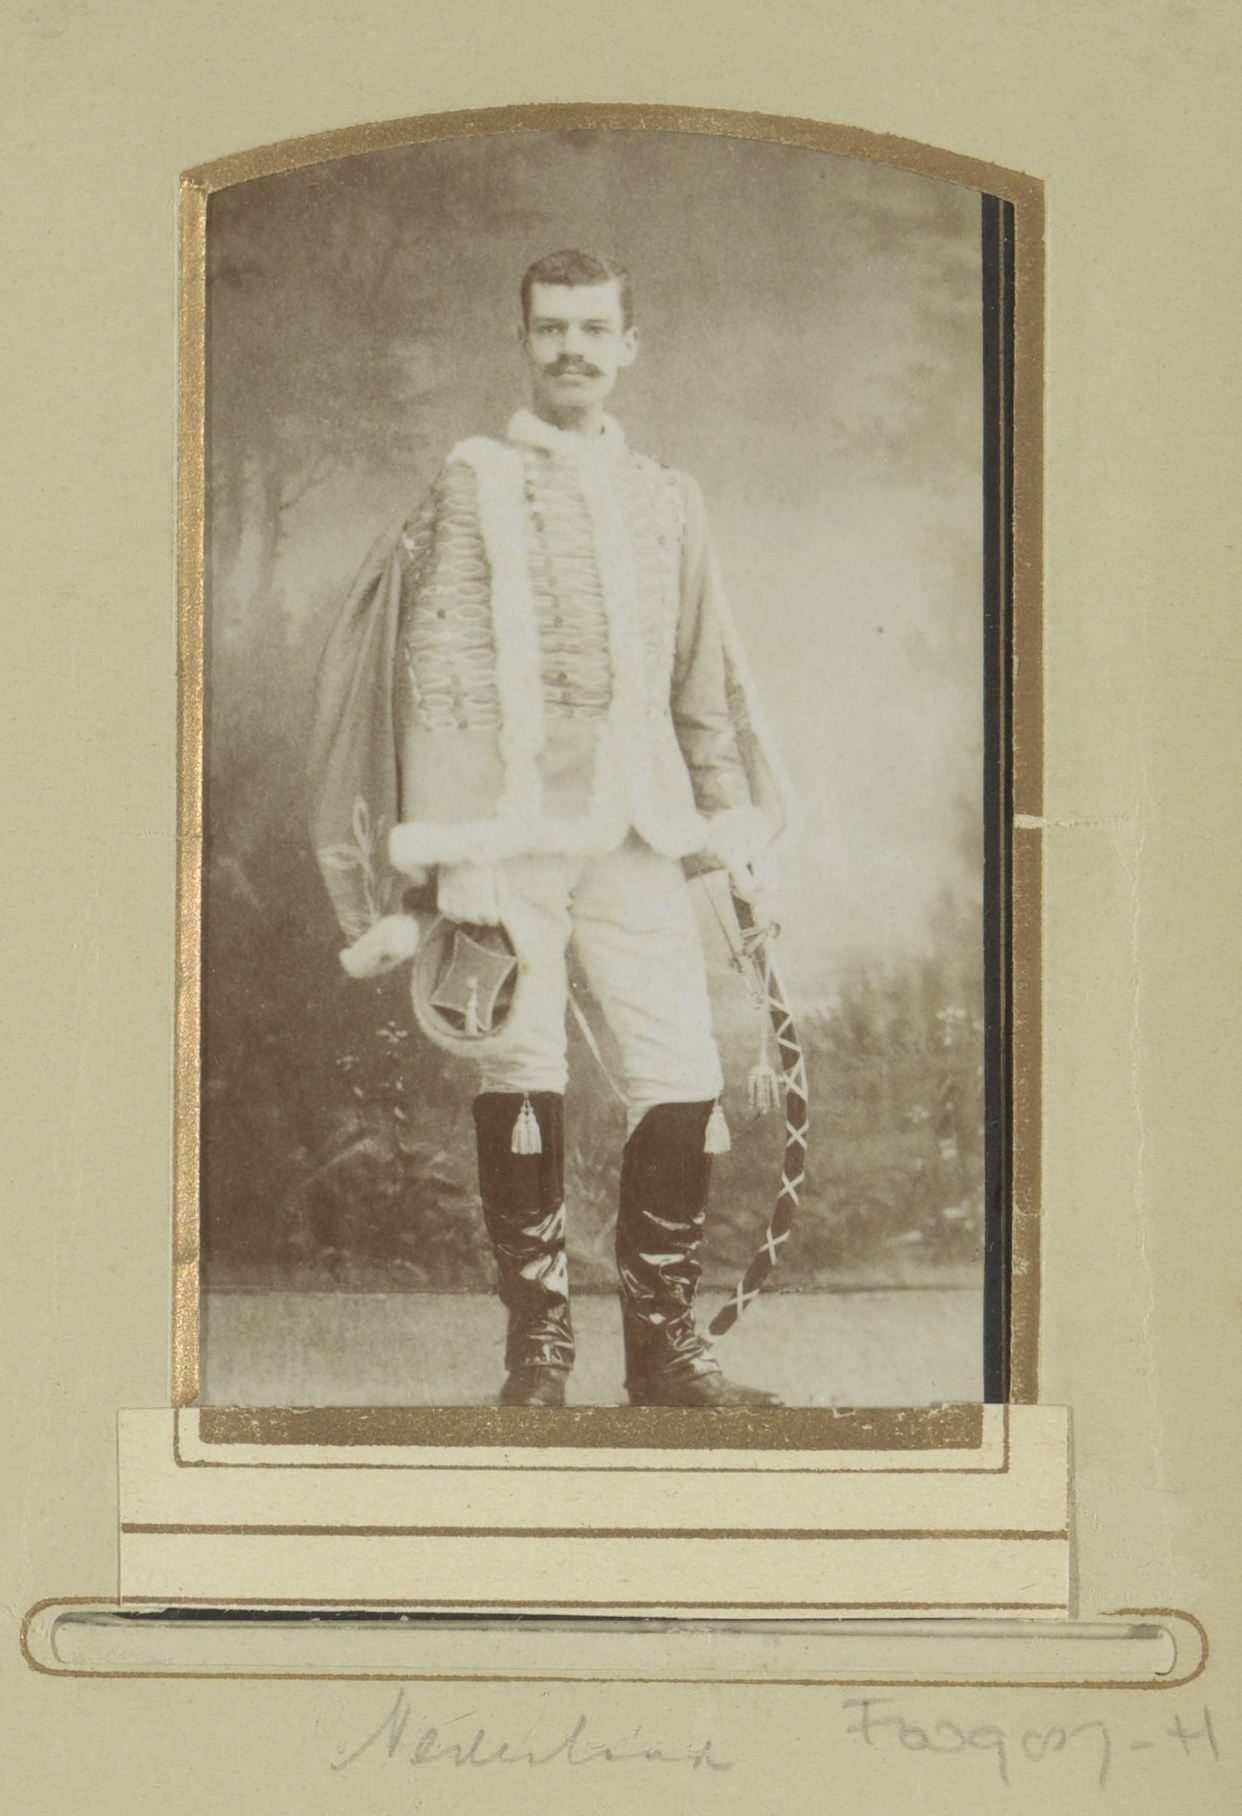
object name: carte de visite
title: Portret van een (vermoedelijk) Nederlandse militair, staand met sabel en cape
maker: johannes gesterkamp jr.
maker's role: painter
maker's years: 1859-1937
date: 1886-1901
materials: cardboard, paper, photographic support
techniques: albumen print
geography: utrecht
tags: studio requisites ~ photographer, warfare; military affairs, (military) uniforms, division of armed forces, utrecht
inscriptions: address: ‘Weerdsingel No. 27, tusschen de Weerd- Noorderbruggen. Utrecht.’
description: Onderdeel van Album met cartes-de-visite en kabinetfoto's van militairen in uniform.